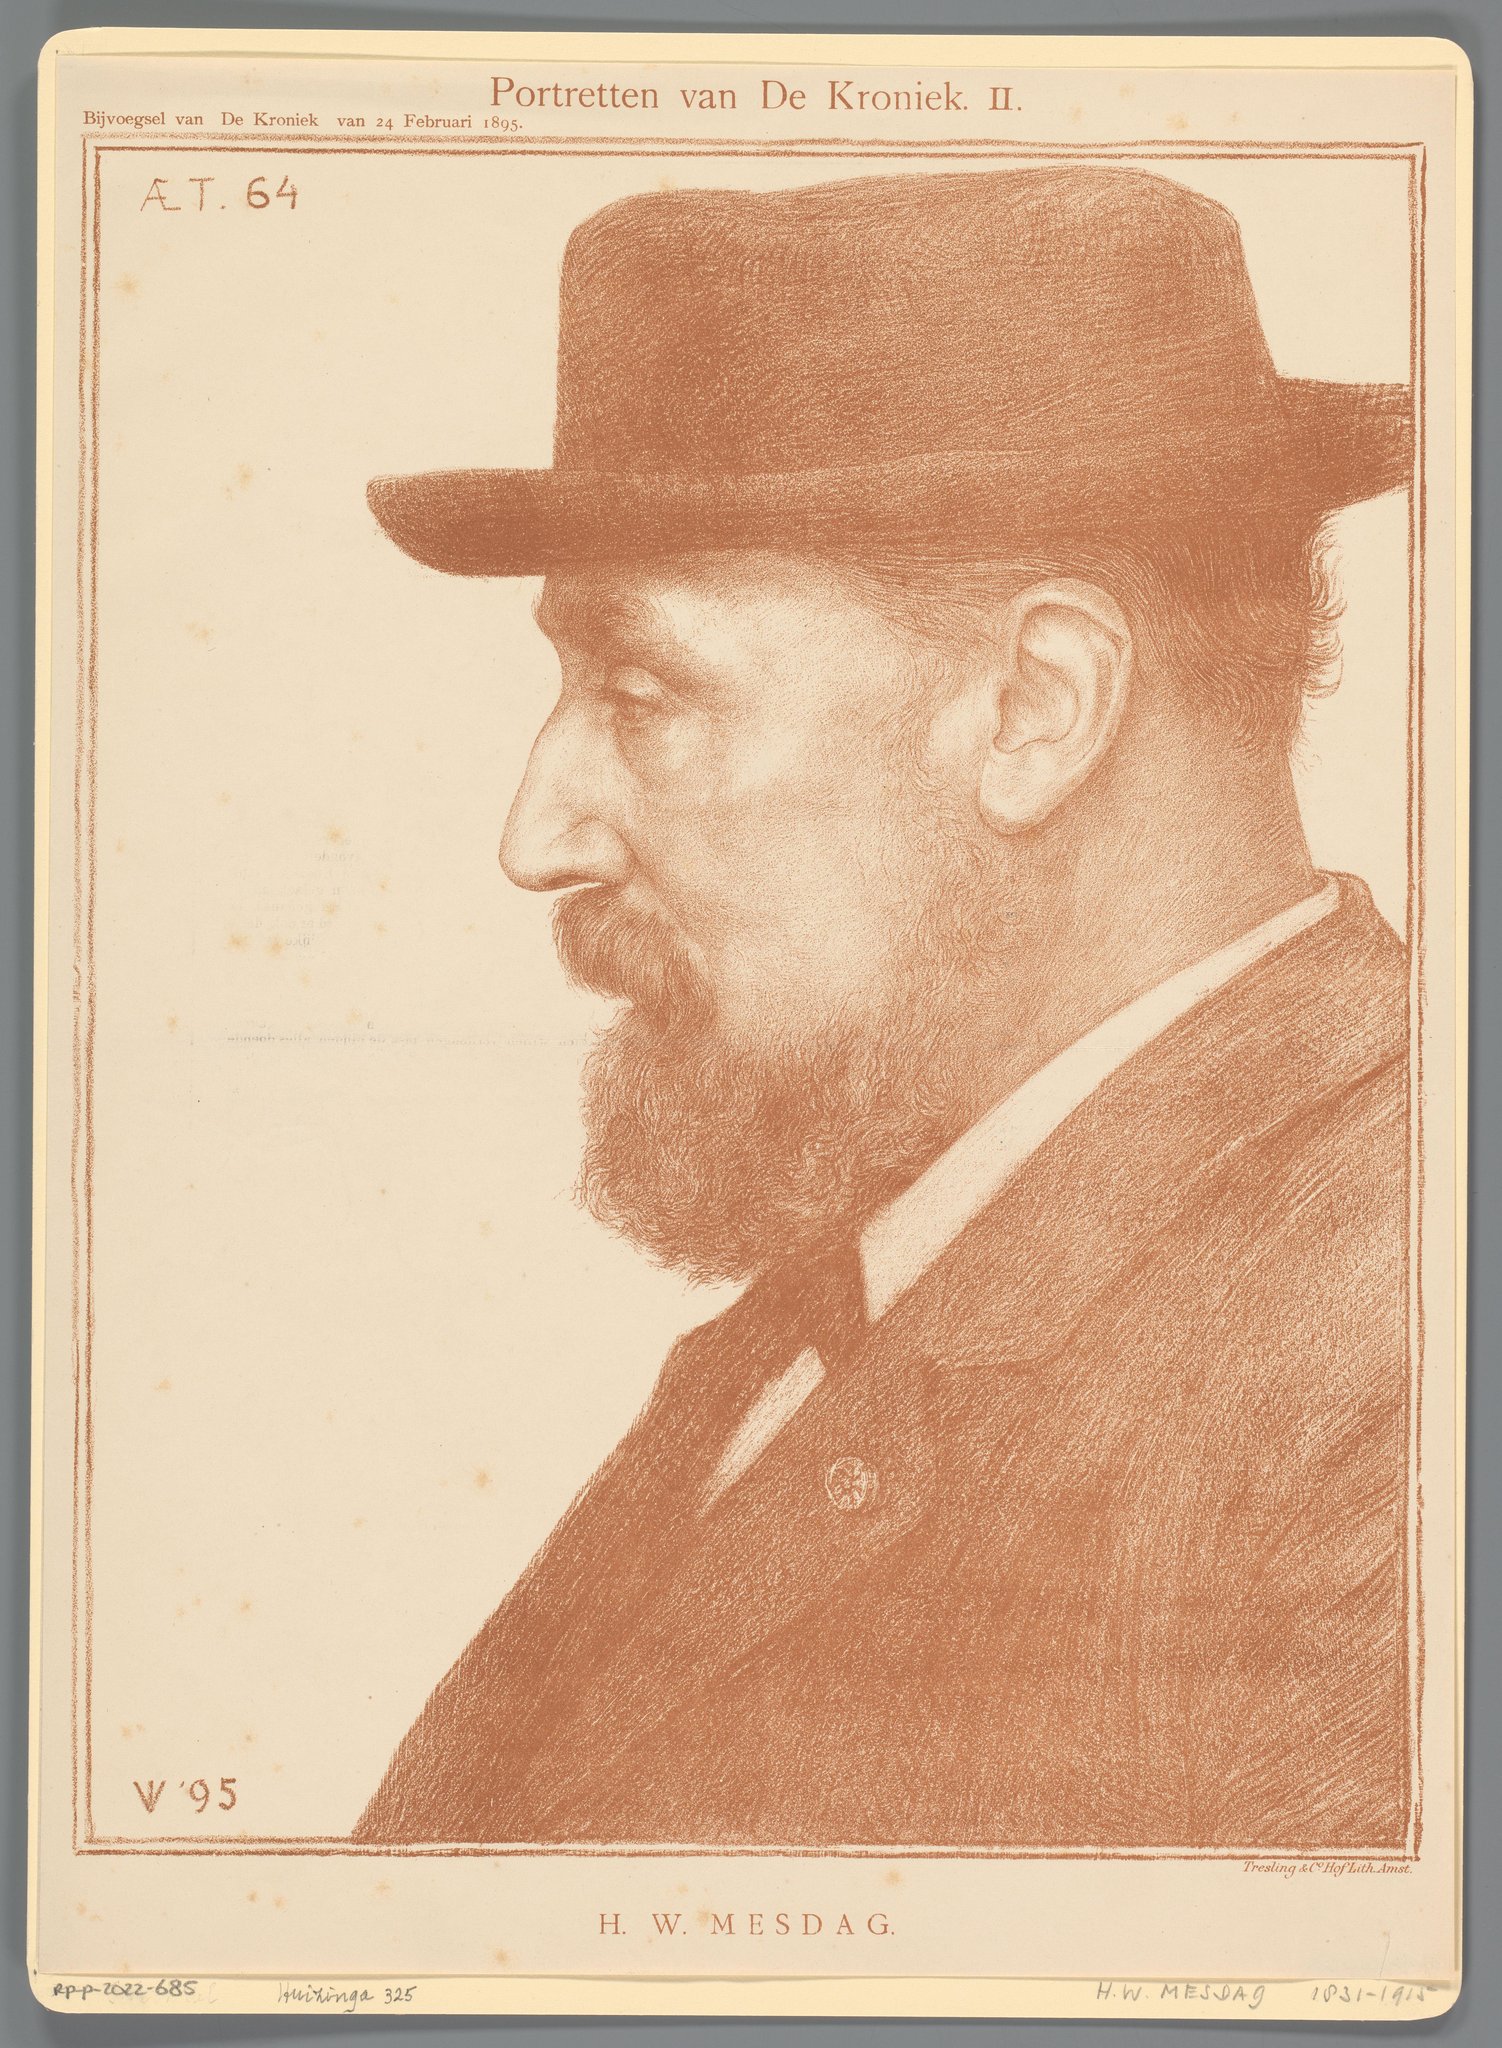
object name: print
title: Portret van Hendrik Willem Mesdag op 64-jarige leeftijd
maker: jan veth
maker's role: designer, draughtsman, painter, print maker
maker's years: 1864-1925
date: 1895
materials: paper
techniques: lithograph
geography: amsterdam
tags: the hague, hendrik willem mesdag, historical persons, portrait, self-portrait of painter